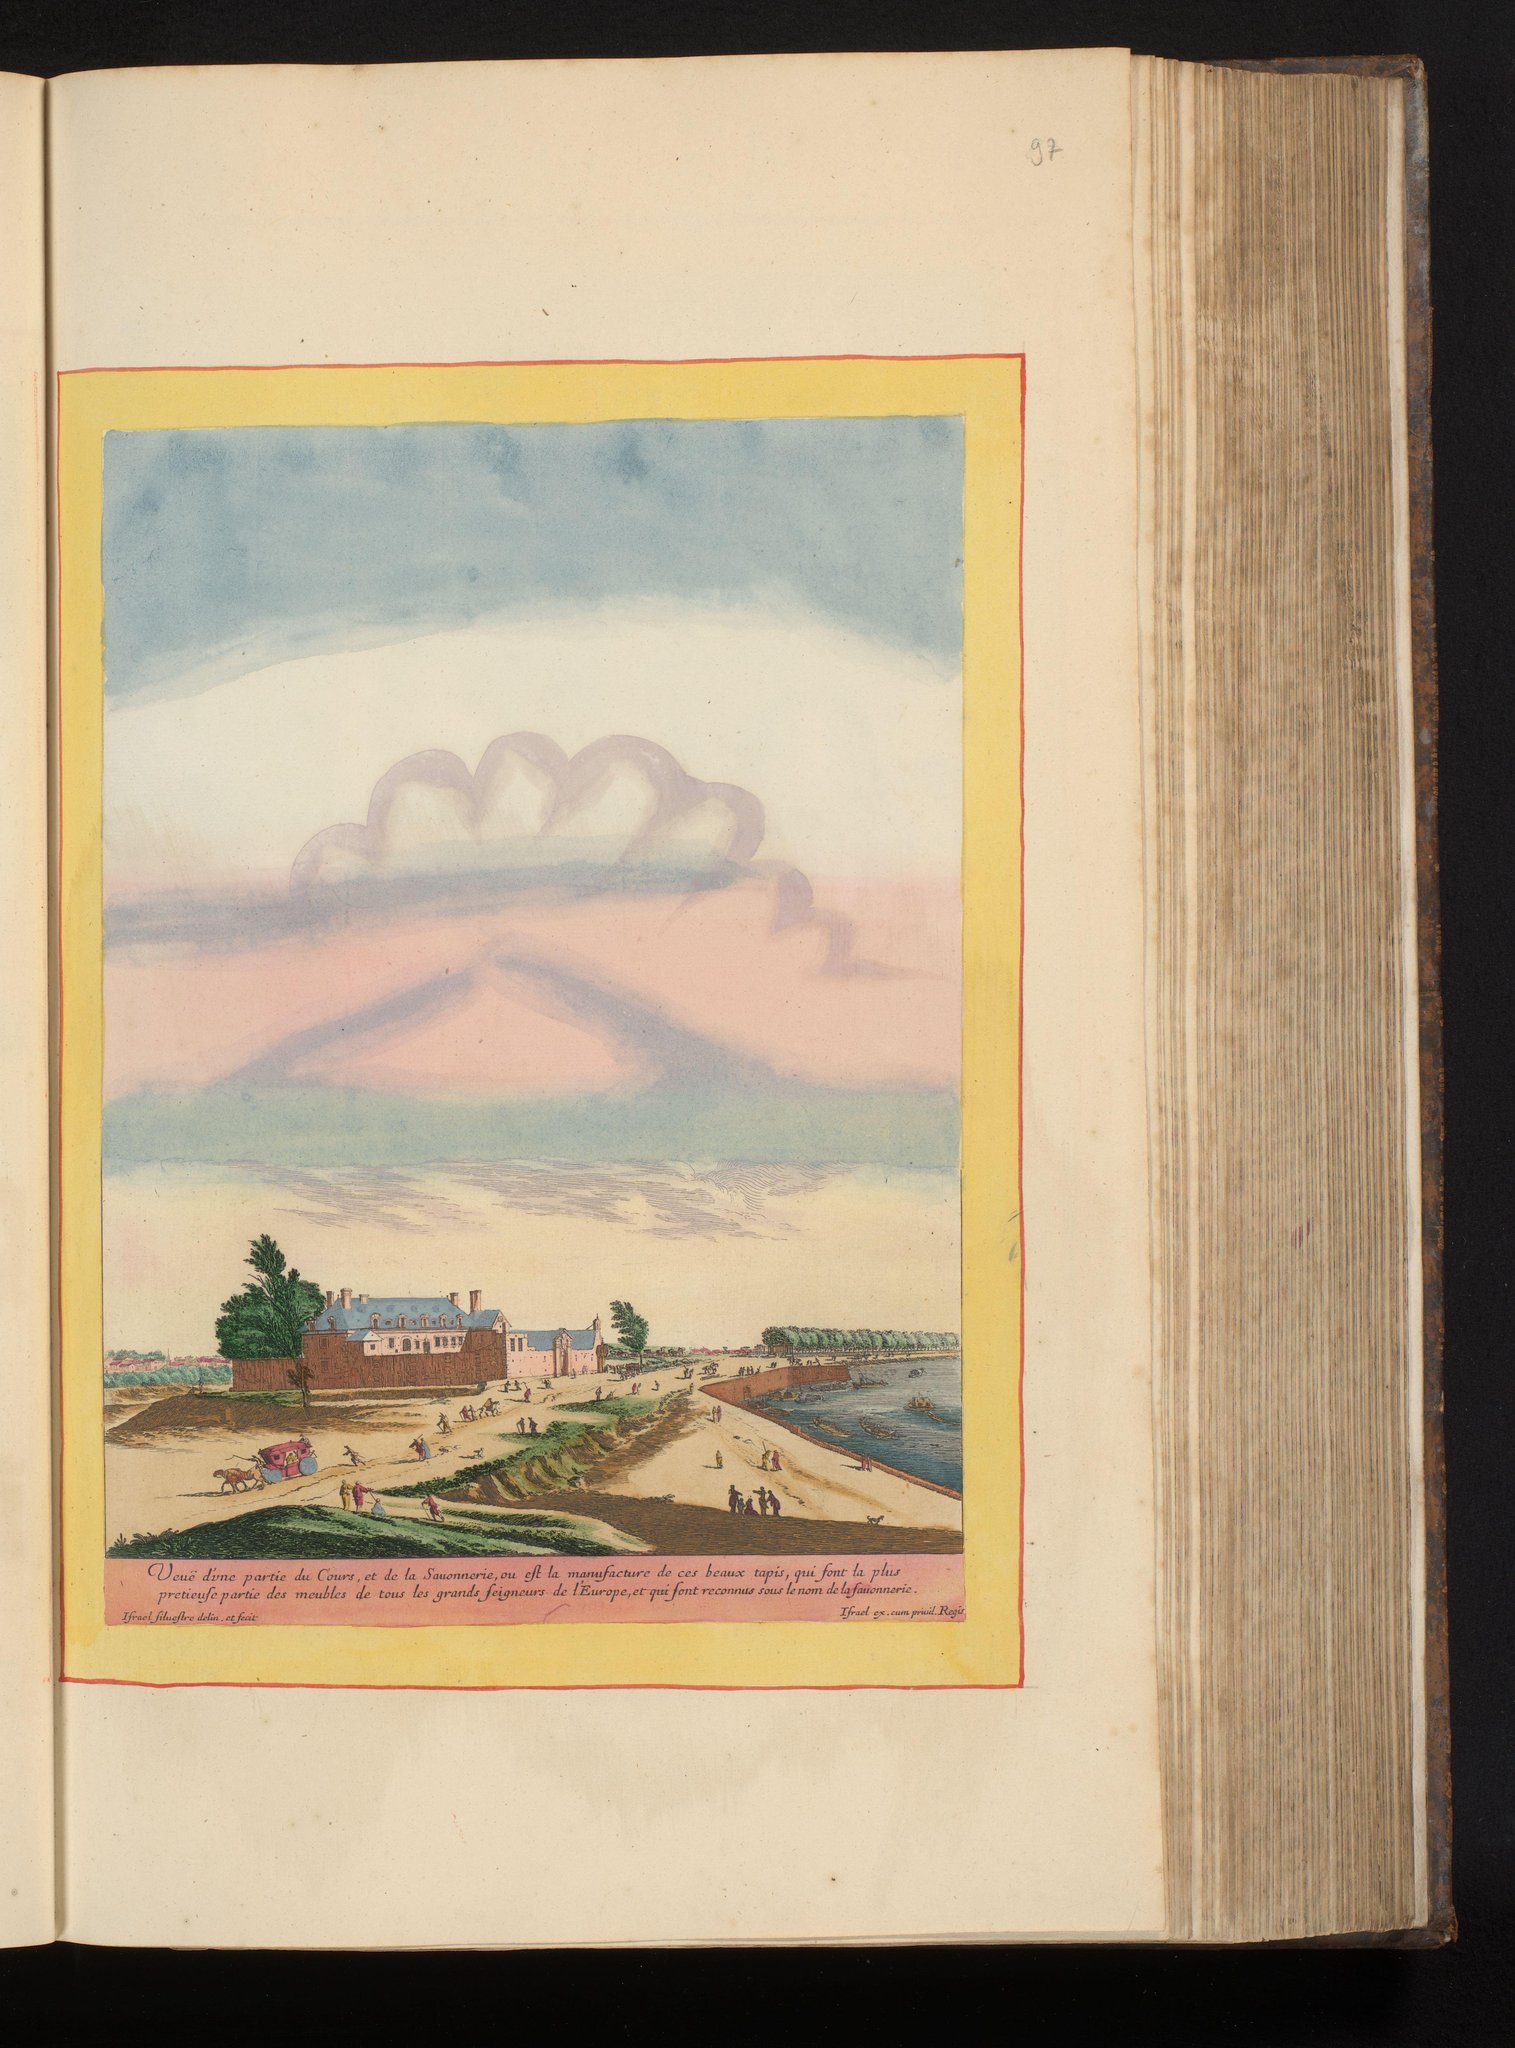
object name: print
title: Veuë d'une partie du Cours, et de la Savonnerie ou est la manufacture de ces beaux tapis (...)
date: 1631-1661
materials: paper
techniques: etching, hand coloring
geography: paris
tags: tapestry weaver, gobelin maker, france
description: Gezicht op een bedrijf aan een rivier waar tapijten worden vervaardigd. Prent maakt deel uit van een album.